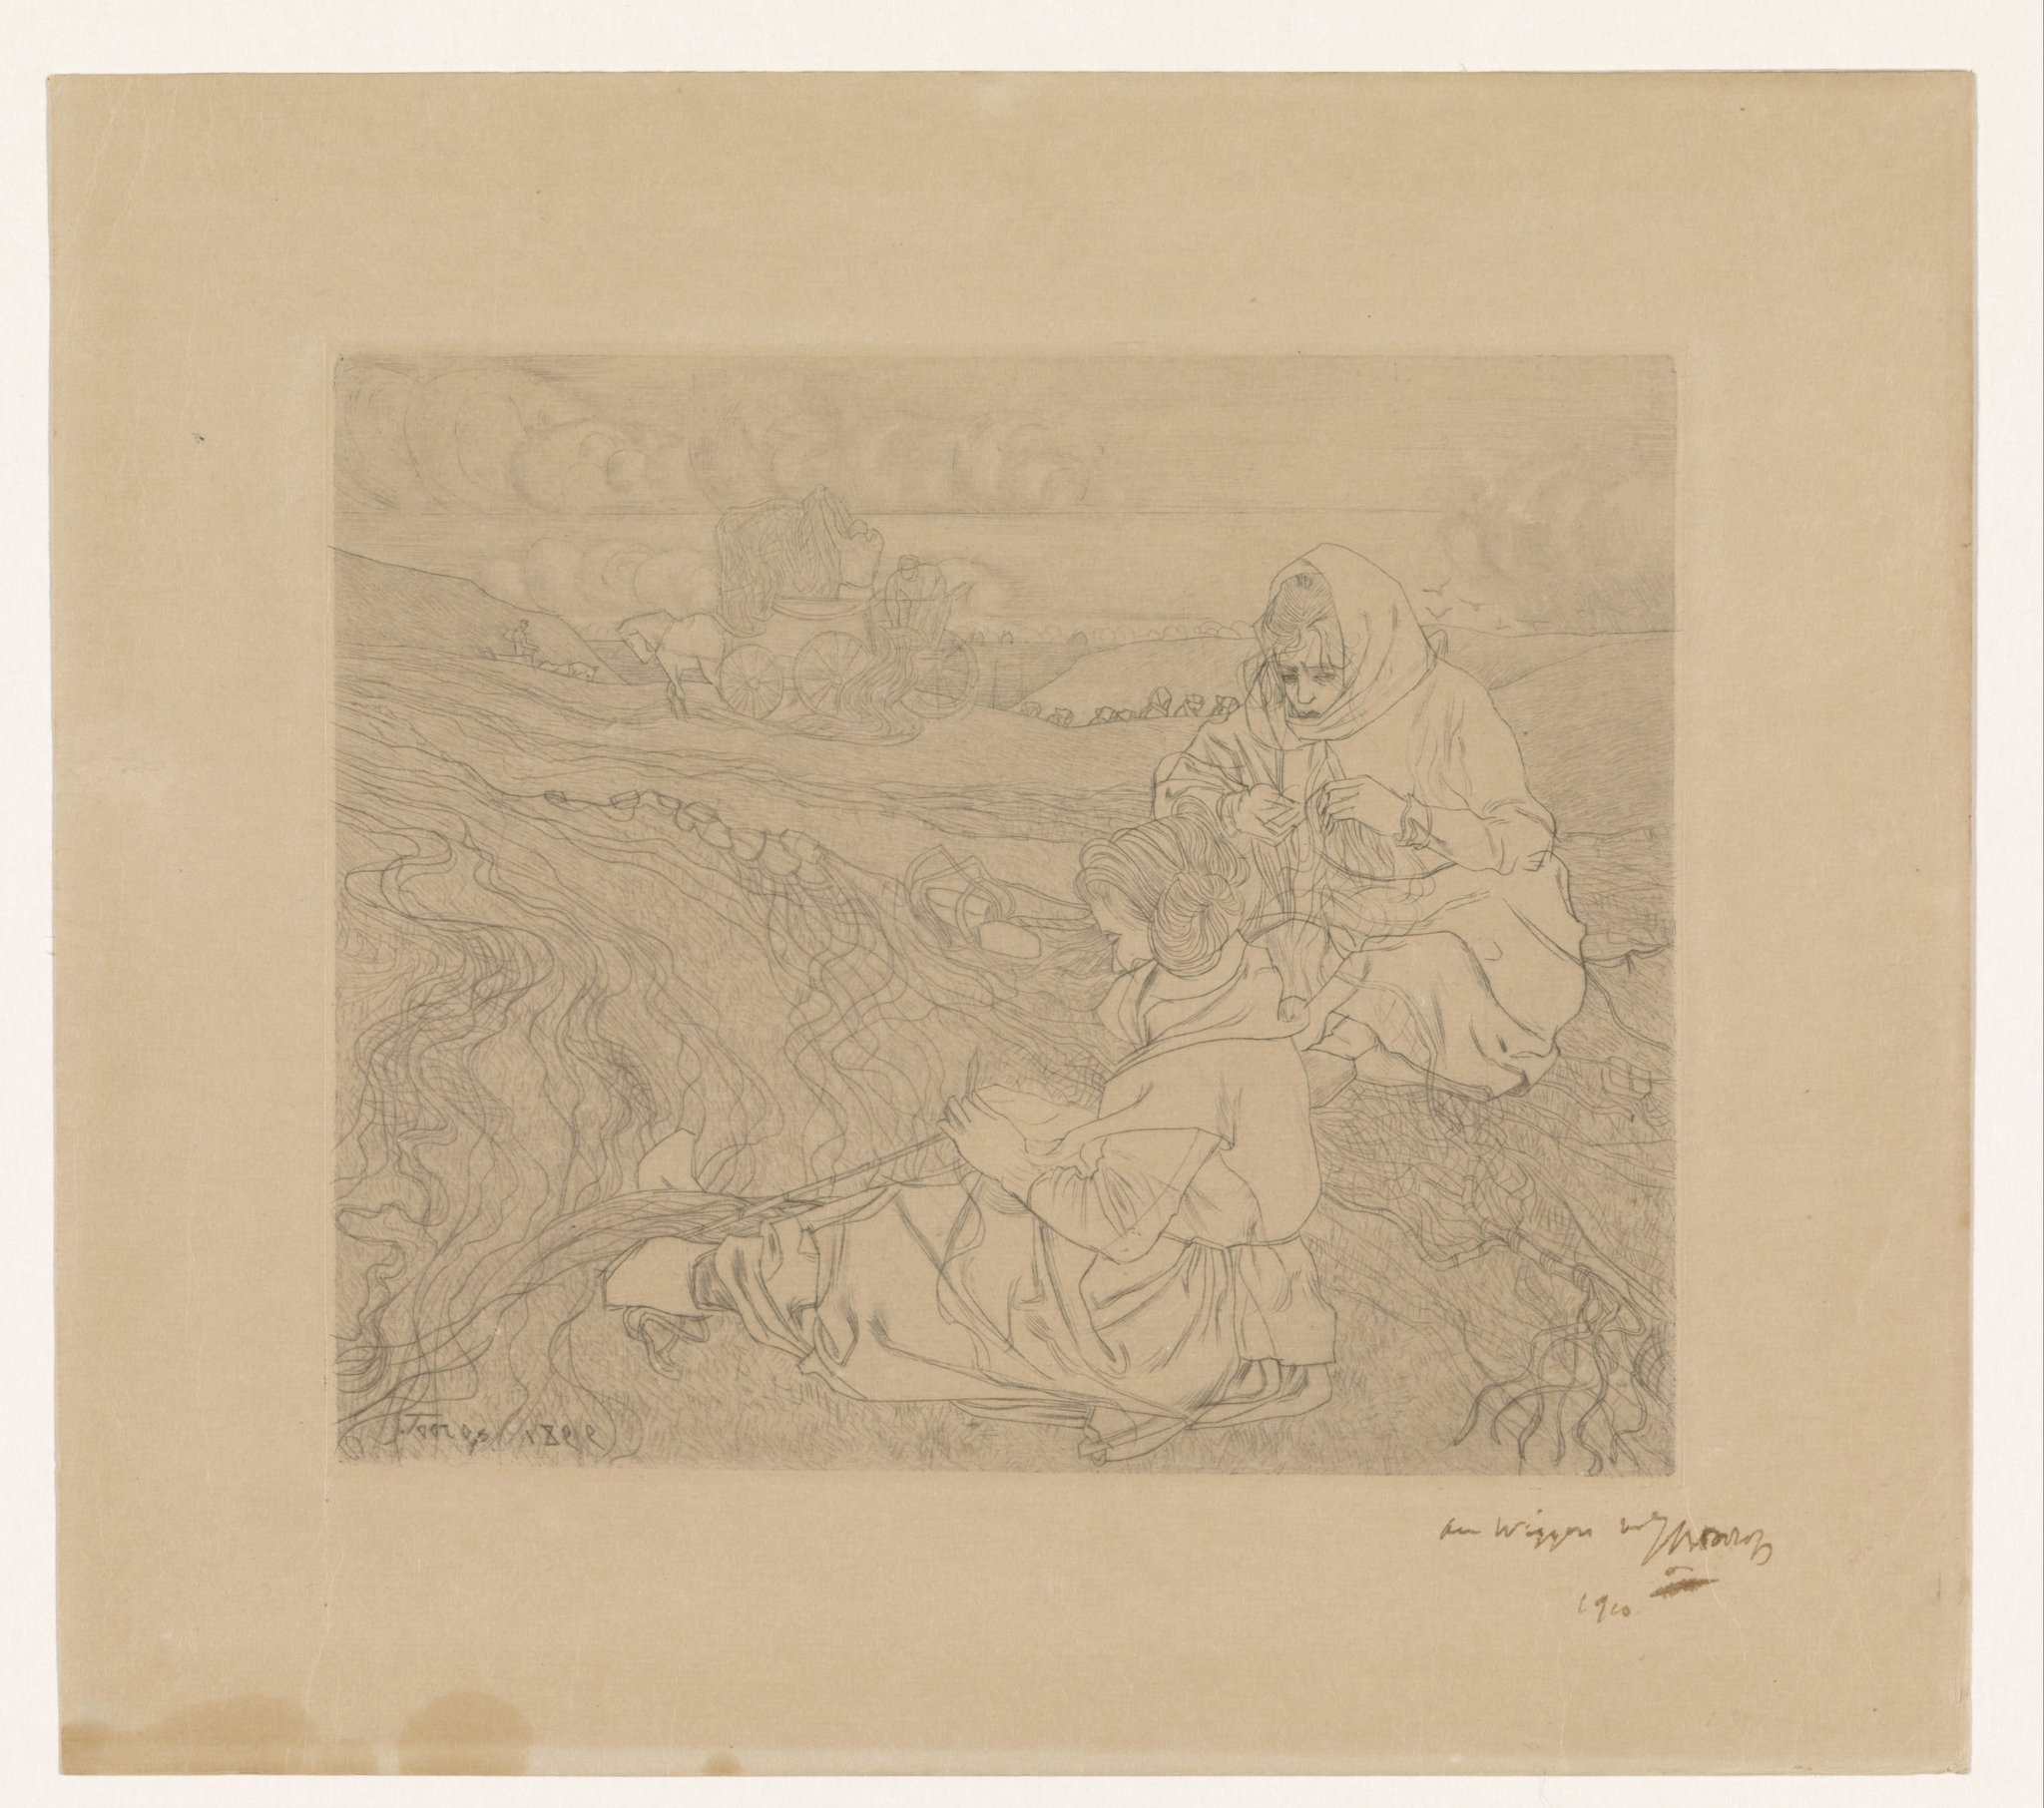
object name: print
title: Twee vrouwen die netten boeten, te Katwijk aan Zee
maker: jan toorop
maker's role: draughtsman, painter, print maker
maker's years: 1858-1928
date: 1899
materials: paper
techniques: drypoint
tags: mending of fishing nets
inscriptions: dedication: ‘Aan Wiggers/ 1910’, collector's mark: Lugt 2228